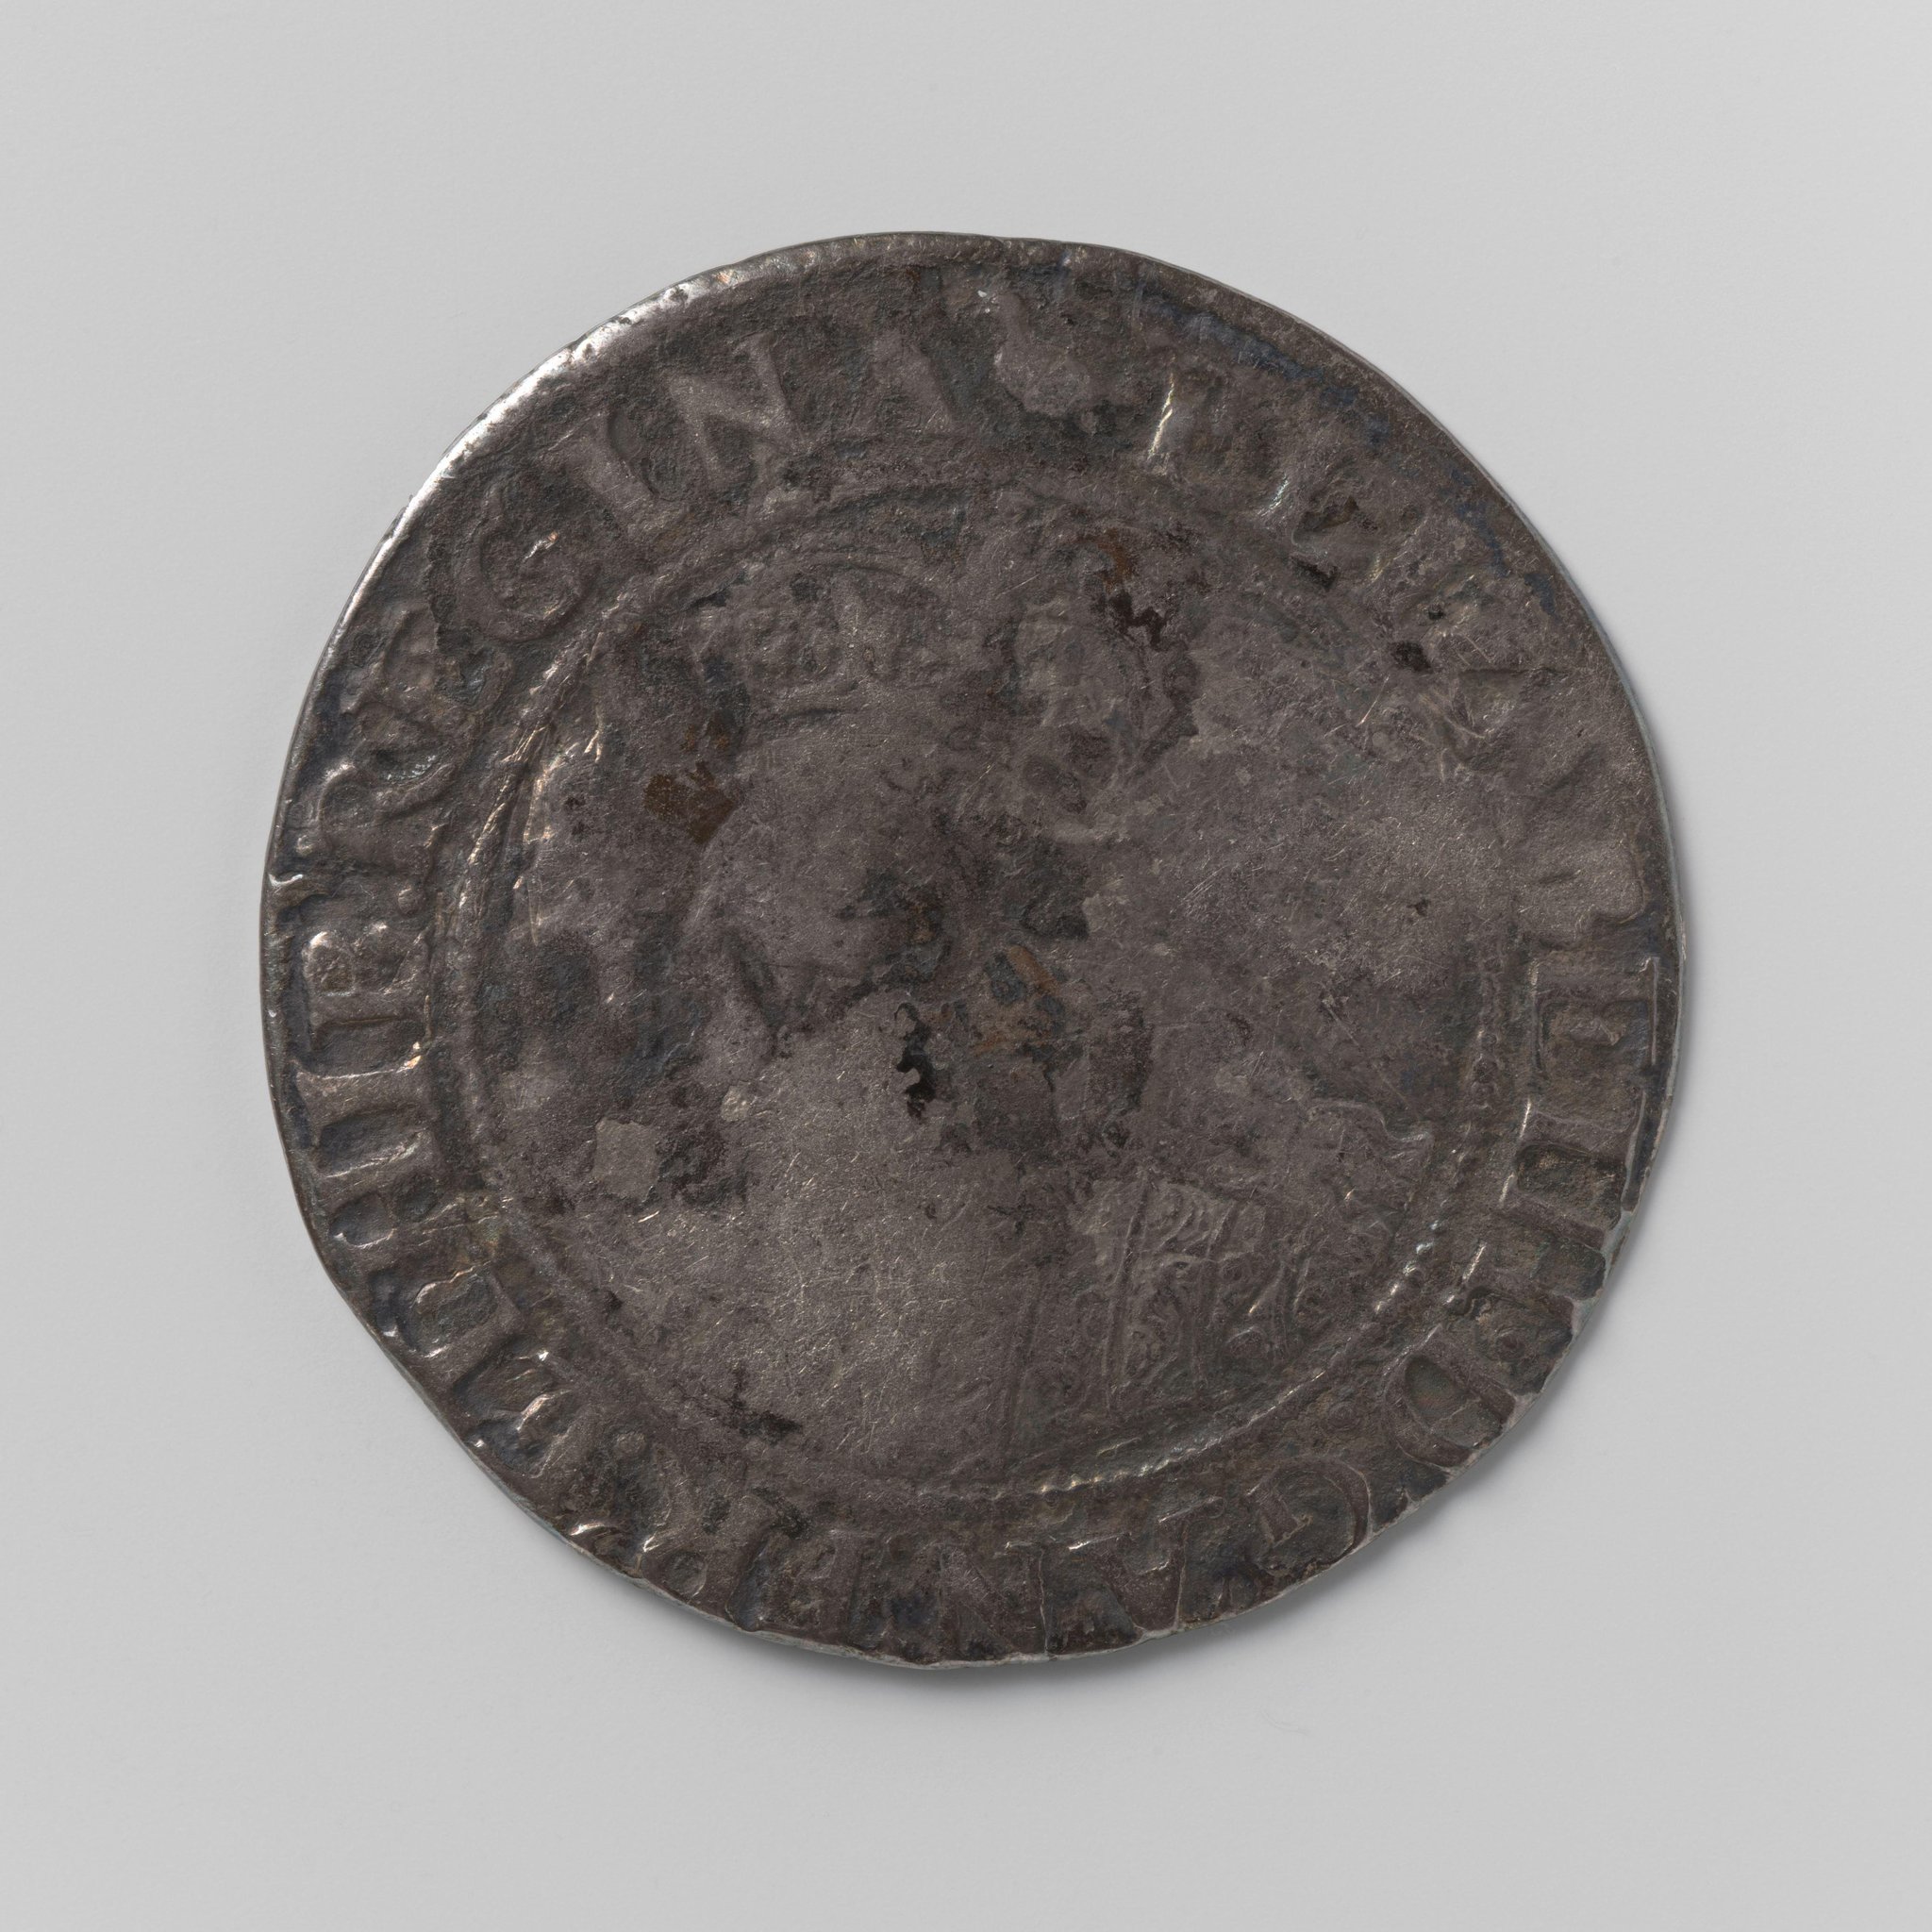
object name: coin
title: Engeland, Elisabeth I, shilling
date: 1558-1603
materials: silver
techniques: striking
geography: london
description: Zilveren munt. Voorzijde: gekroond hoofd van de vorstin naar links. Keerzijde: wapenschild op lang gevoet kruis.